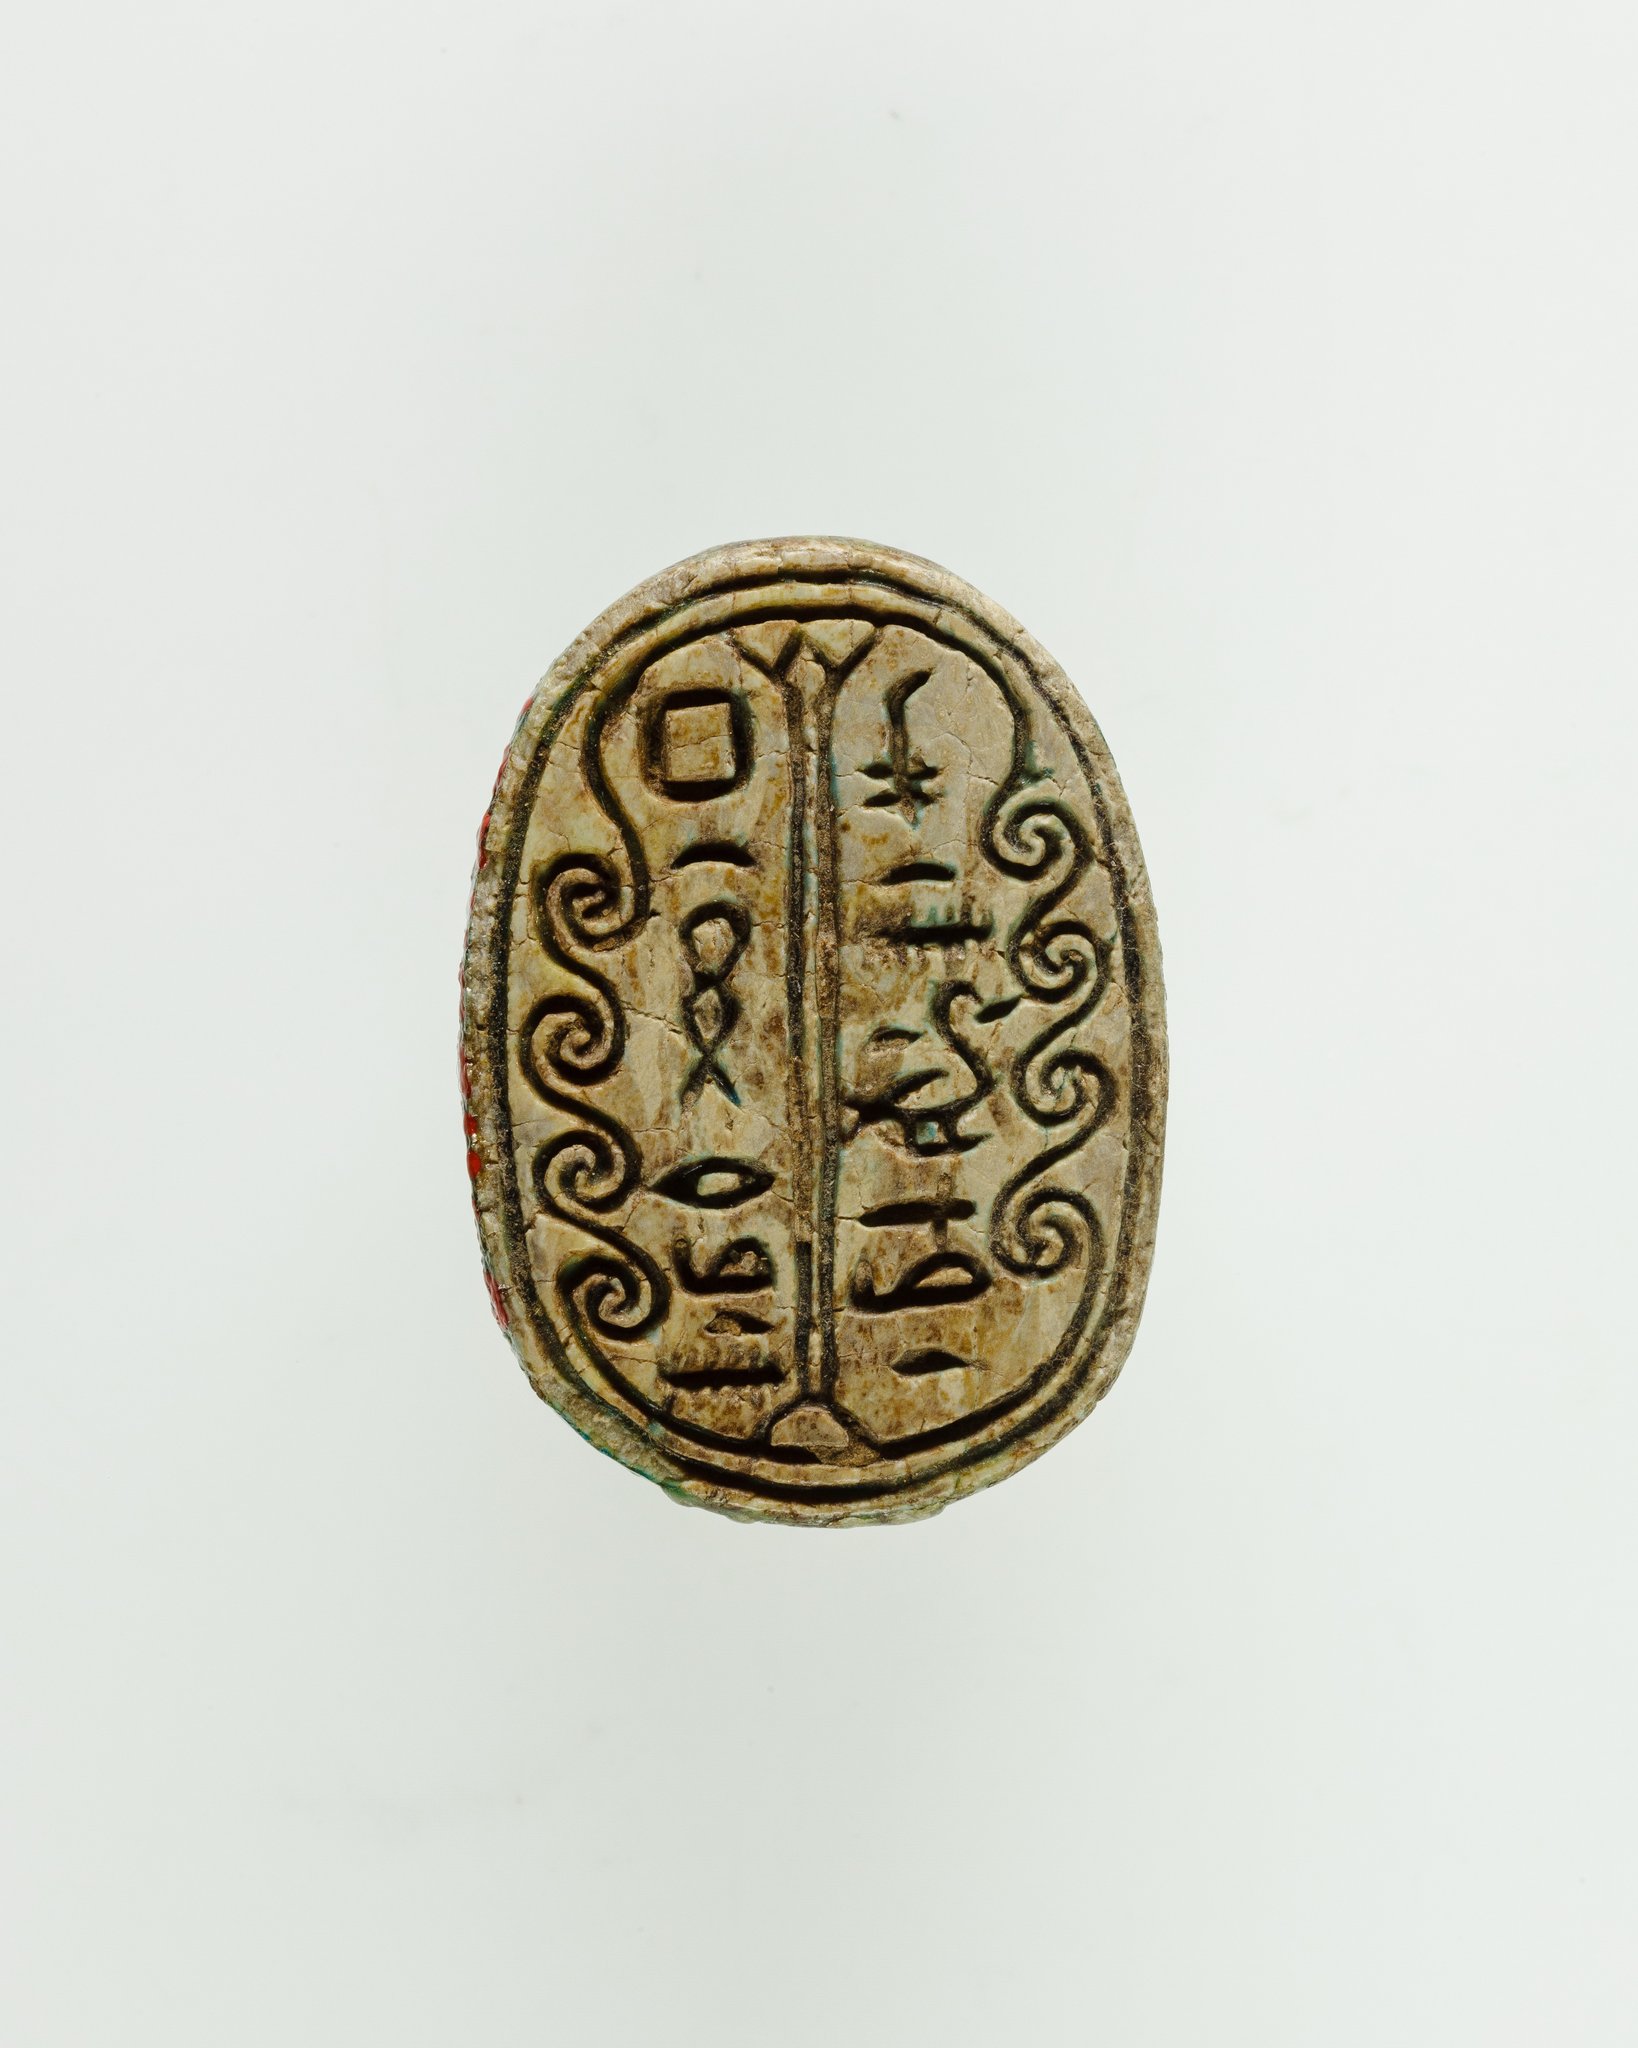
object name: scarab, princess redenptah, scroll border, royal title, lotus flower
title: Scarab of Princess Redenptah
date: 1770-1670 BCE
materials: stone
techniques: glazing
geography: egypt